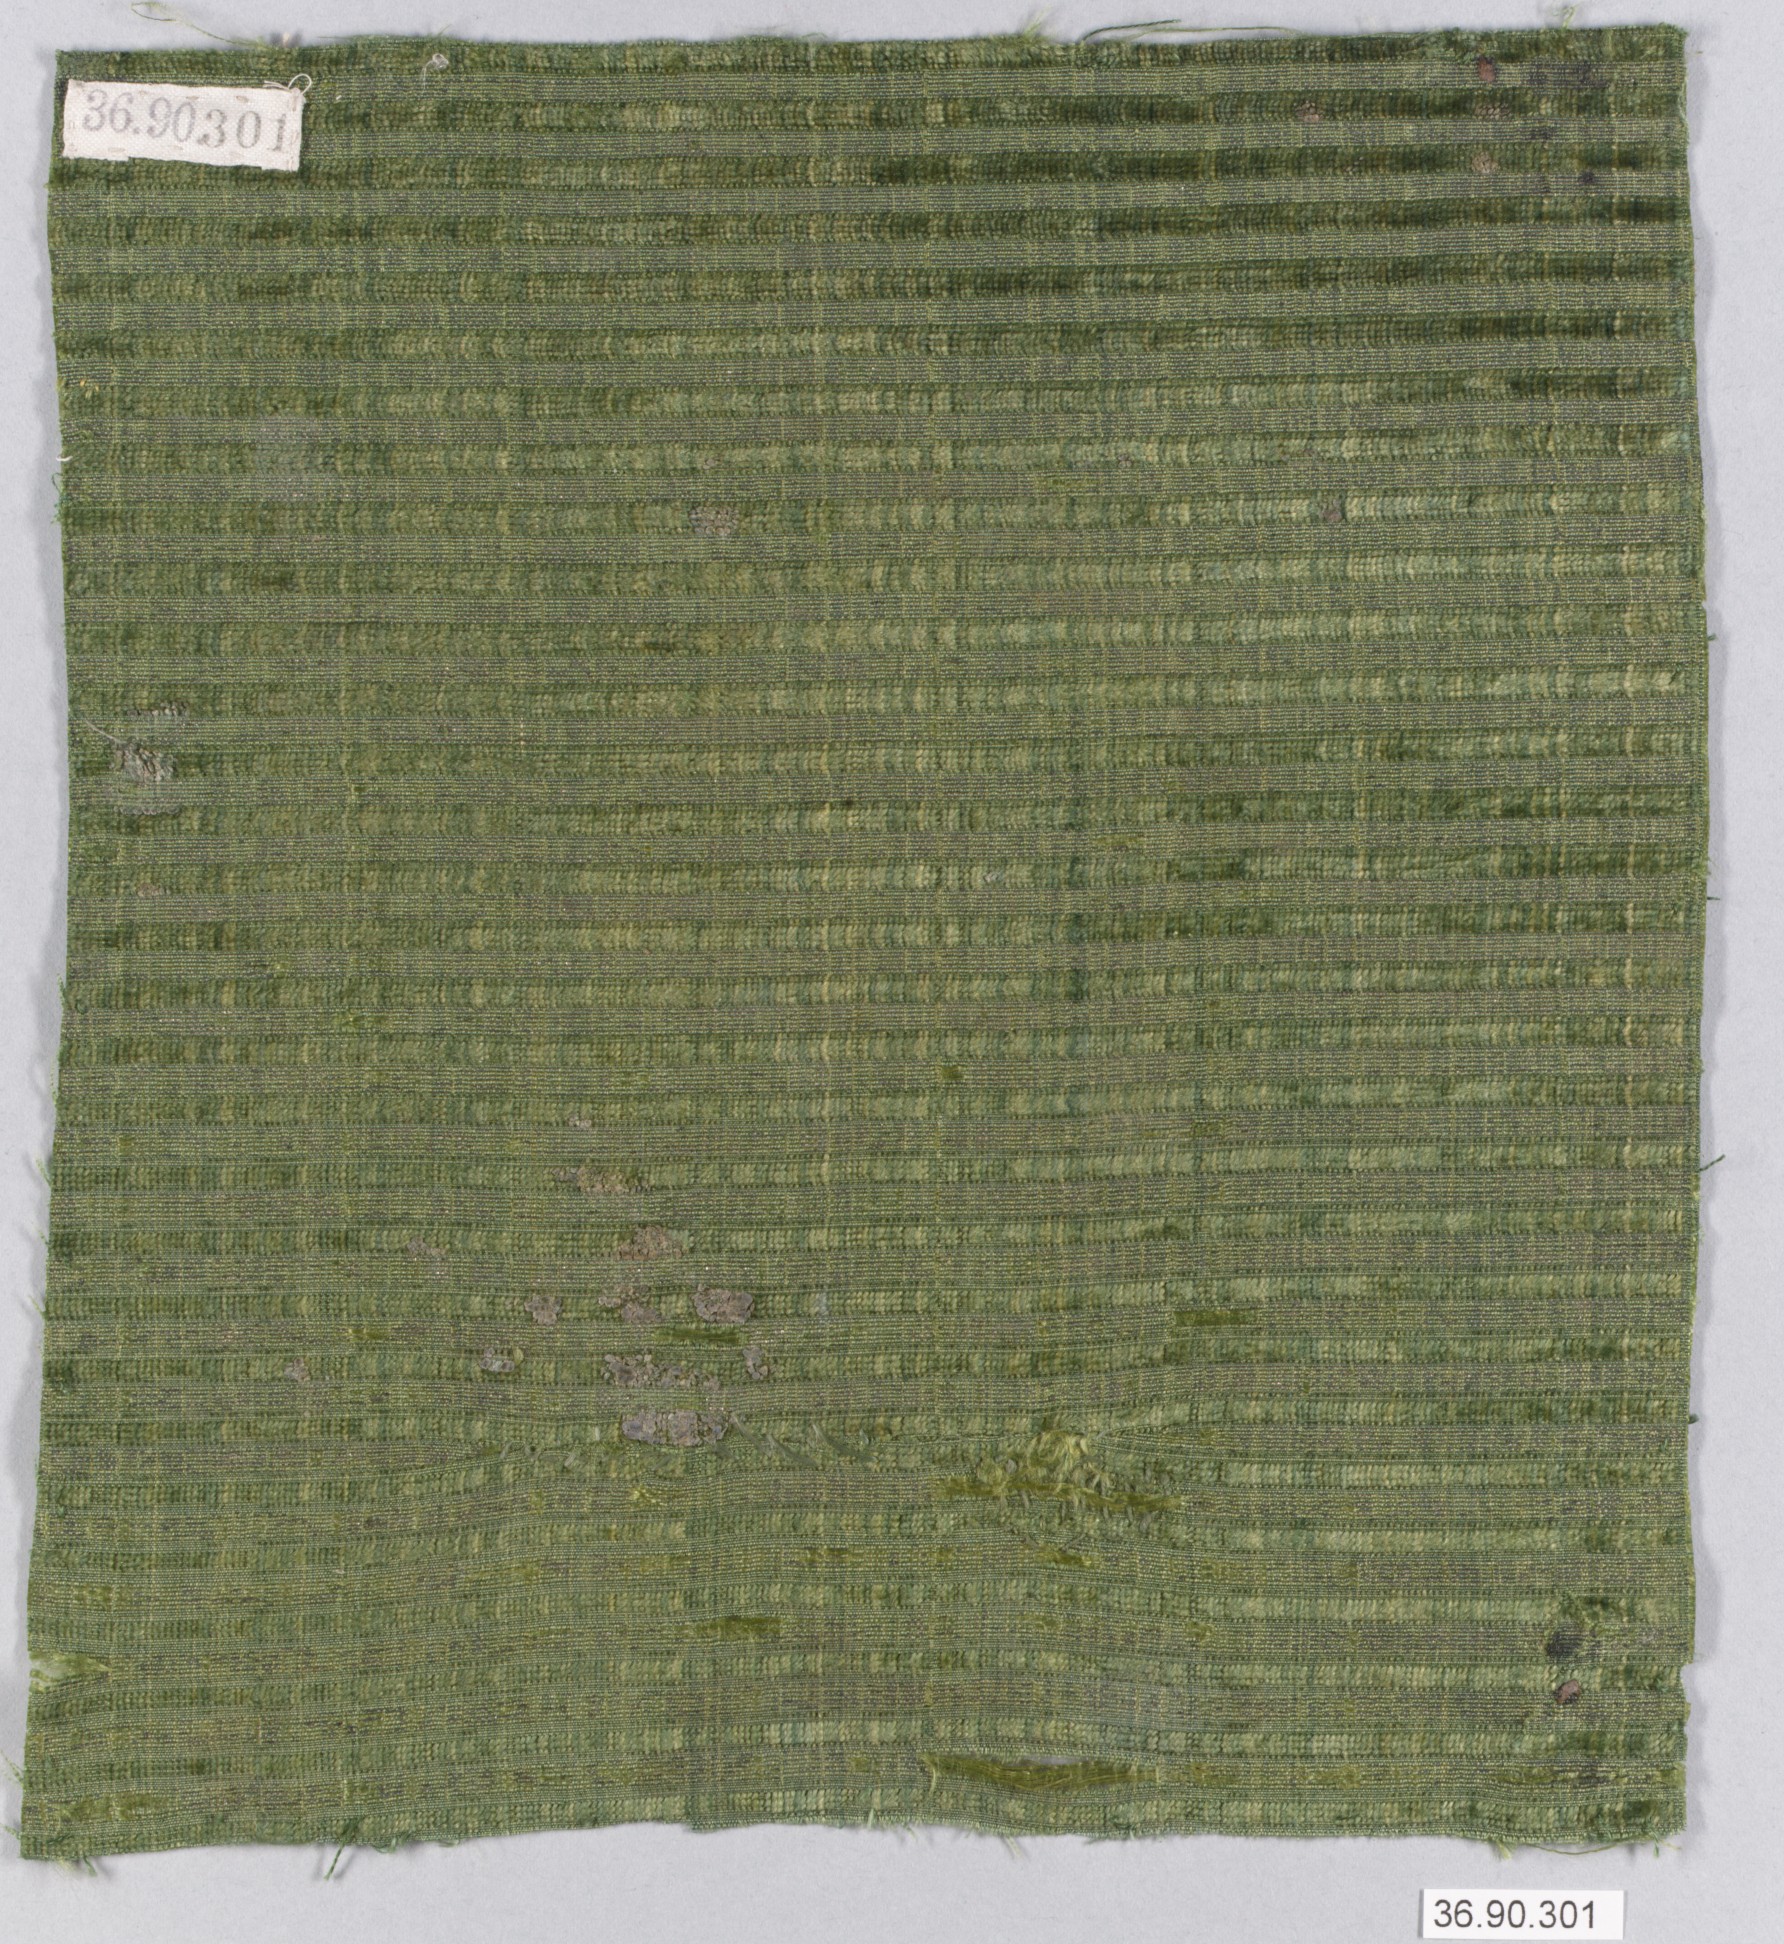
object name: piece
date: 1501-1700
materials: metal thread, silk